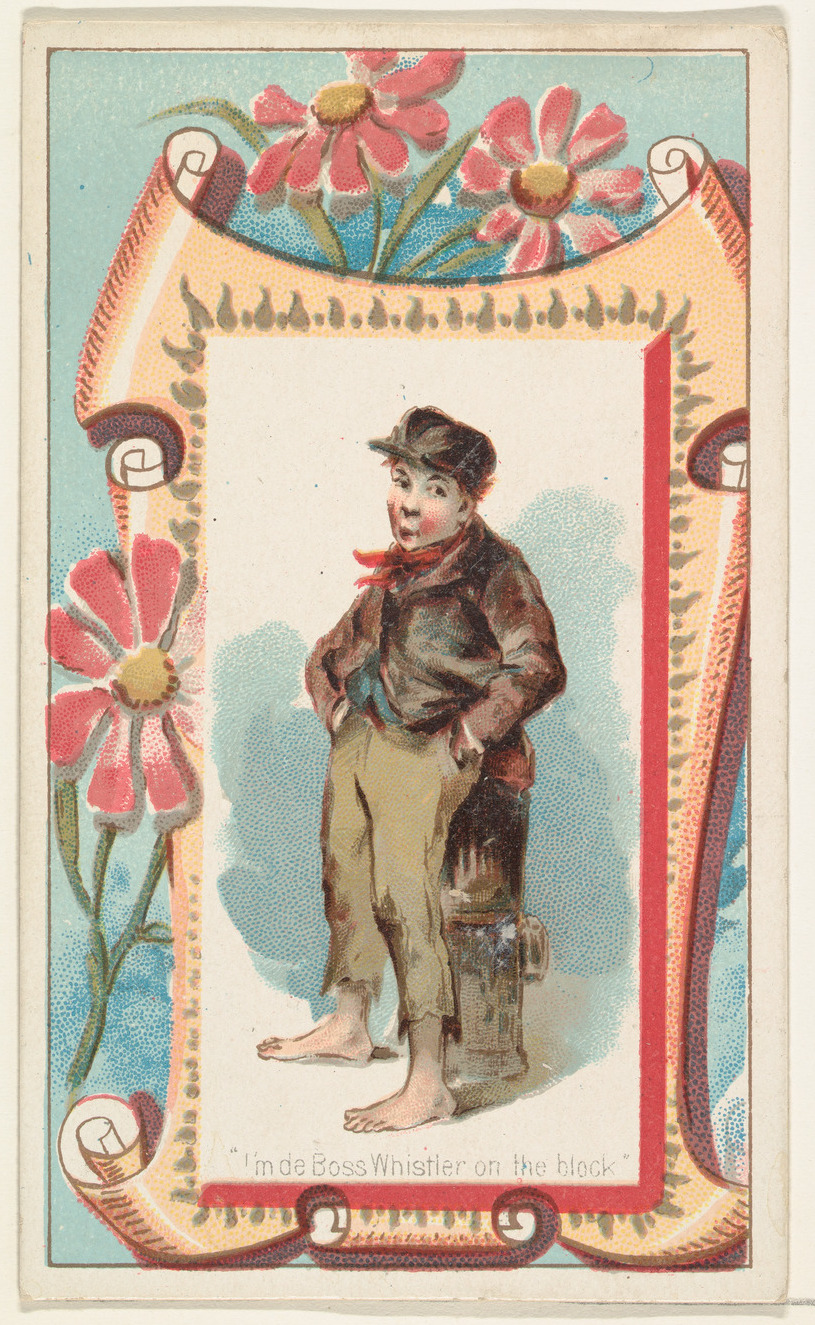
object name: print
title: "I'm de Boss Whistler on the block," from the Terrors of America set (N136) issued by Duke Sons & Co. to promote Honest Long Cut Tobacco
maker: w. duke, sons & co.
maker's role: publisher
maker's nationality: american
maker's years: 1870-1920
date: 1888-1889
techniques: color lithograph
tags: boys